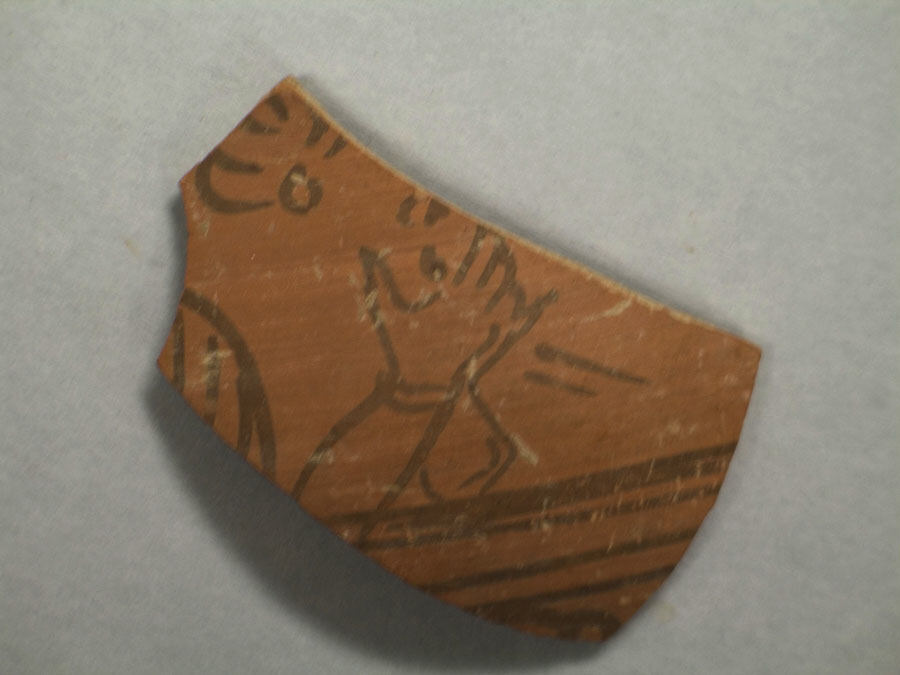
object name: shard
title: Shard: Hand of Offerer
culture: pakistani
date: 301-500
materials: terracotta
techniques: painting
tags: gandhara,hands